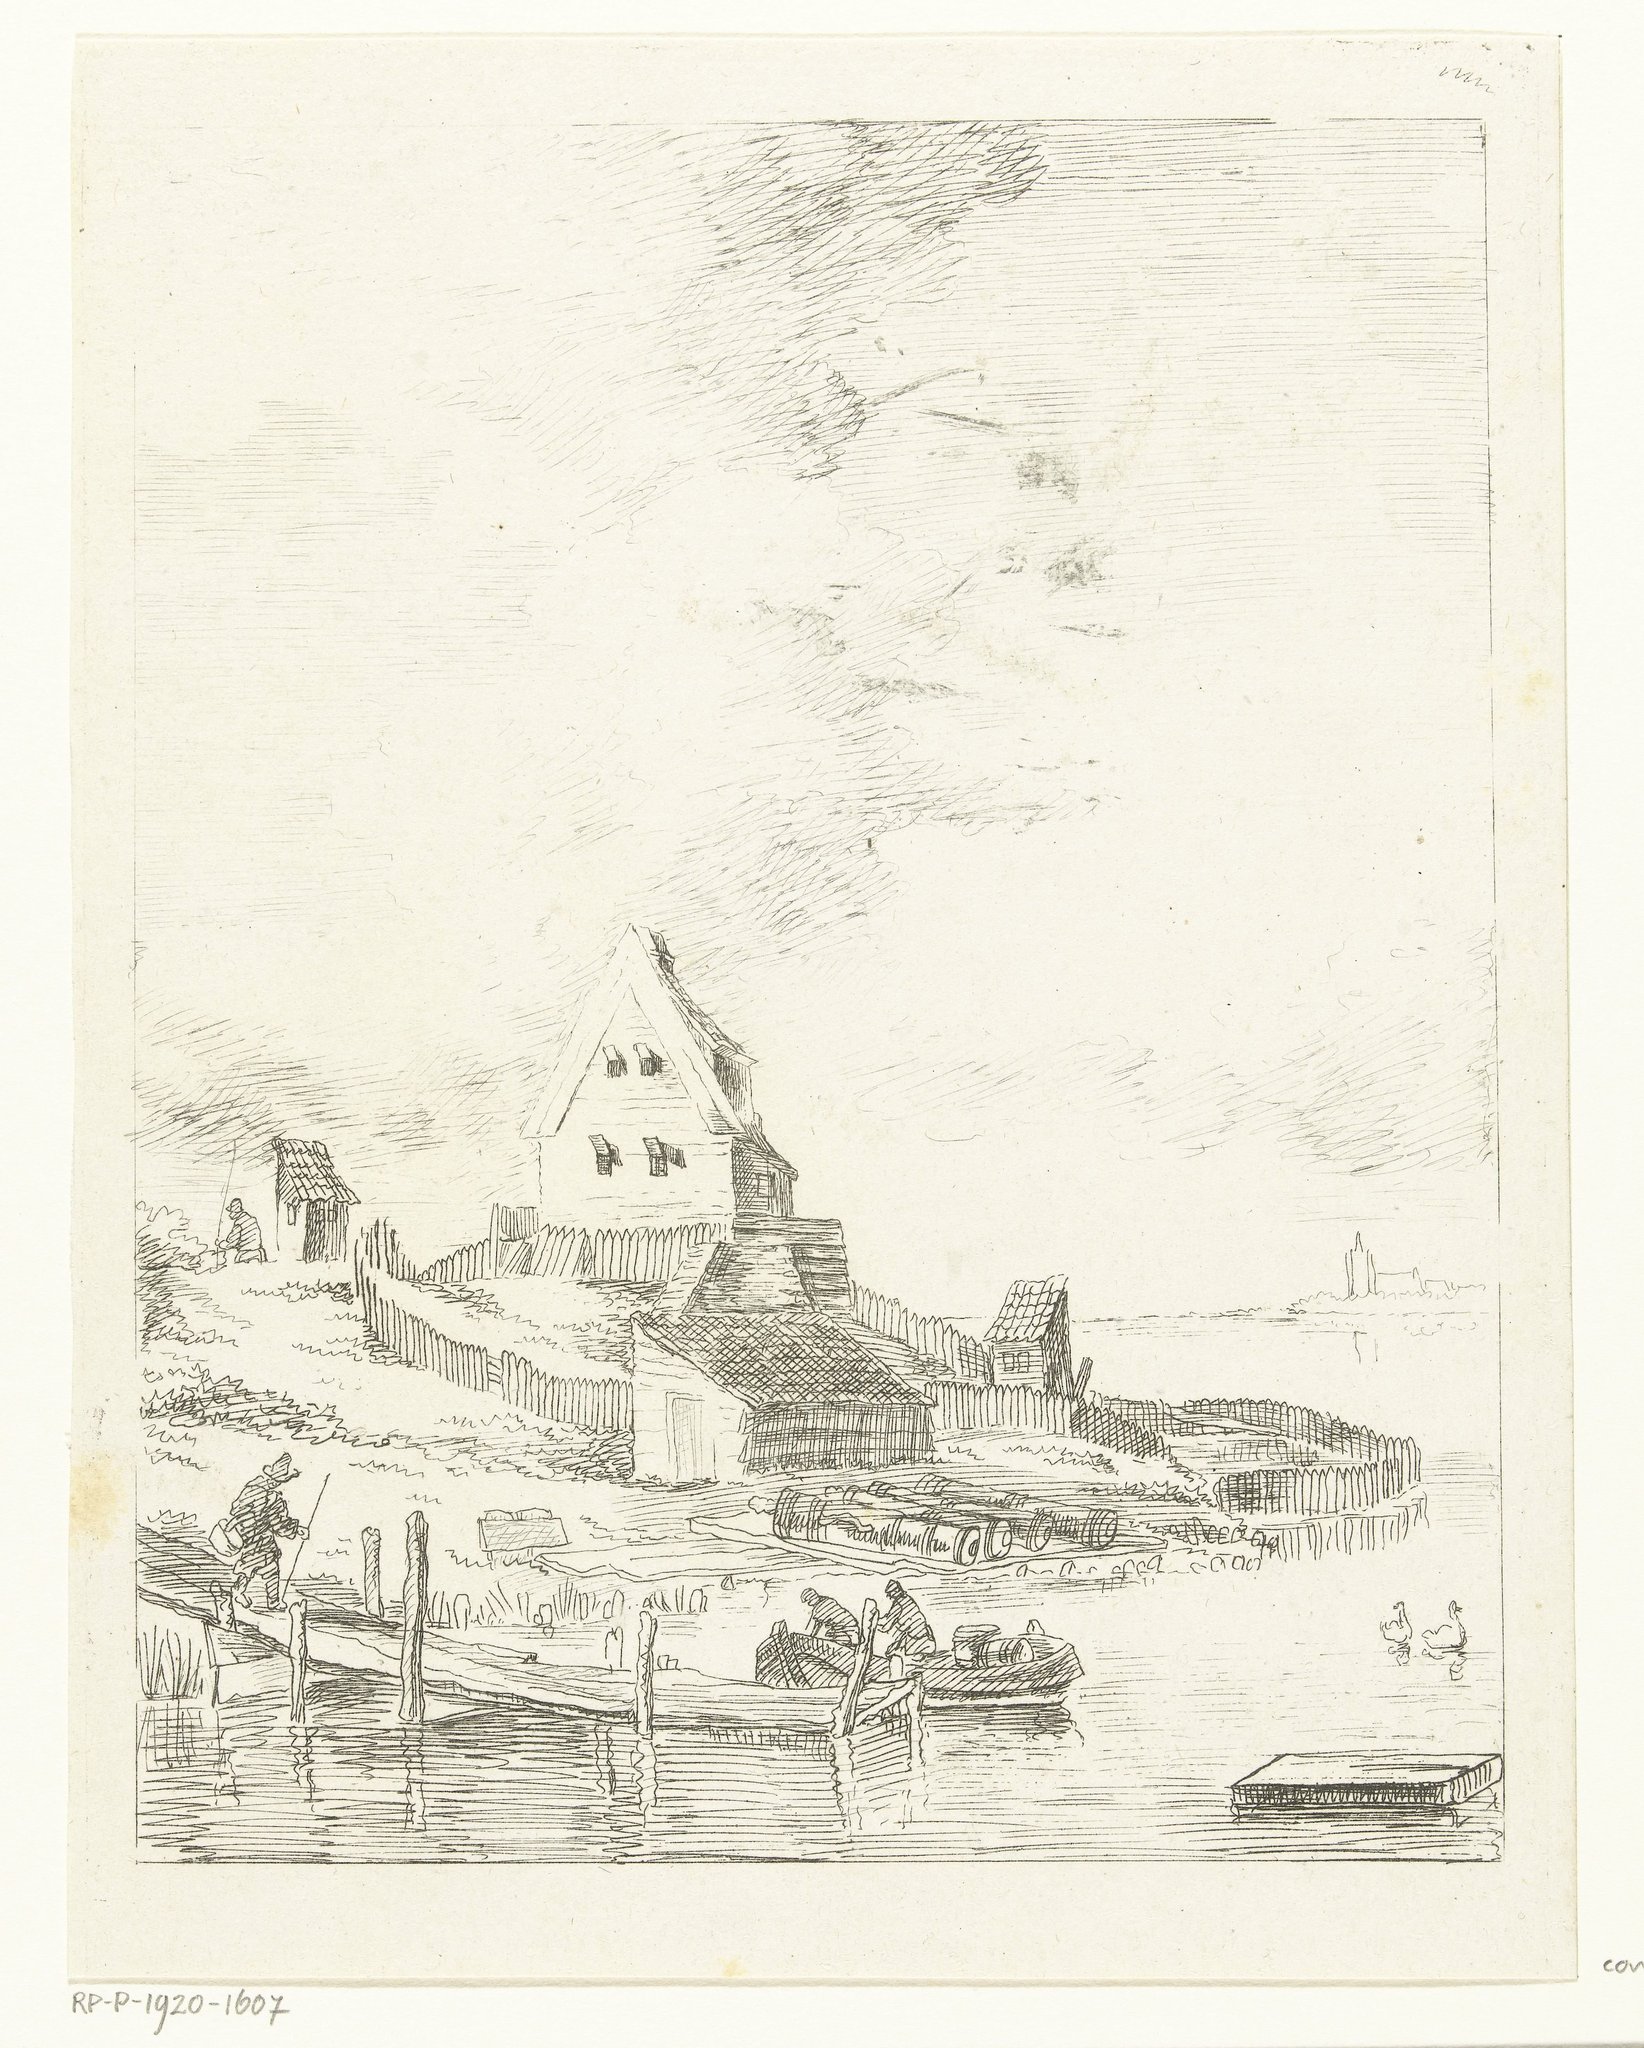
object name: print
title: Landschap met huis en steiger aan rivier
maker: albertus brondgeest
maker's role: draughtsman, print maker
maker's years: 1786-1849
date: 1796-1849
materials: paper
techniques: printmaking, etching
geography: netherlands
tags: water course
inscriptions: collector's mark: Lugt 2233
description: Landschap met huis op hooggelegen oever omgeven door water van rivier. Op de oever liggen vier lopen van kannonen. Een kleine boot ligt bij een steiger waarop een man met emmer loopt.